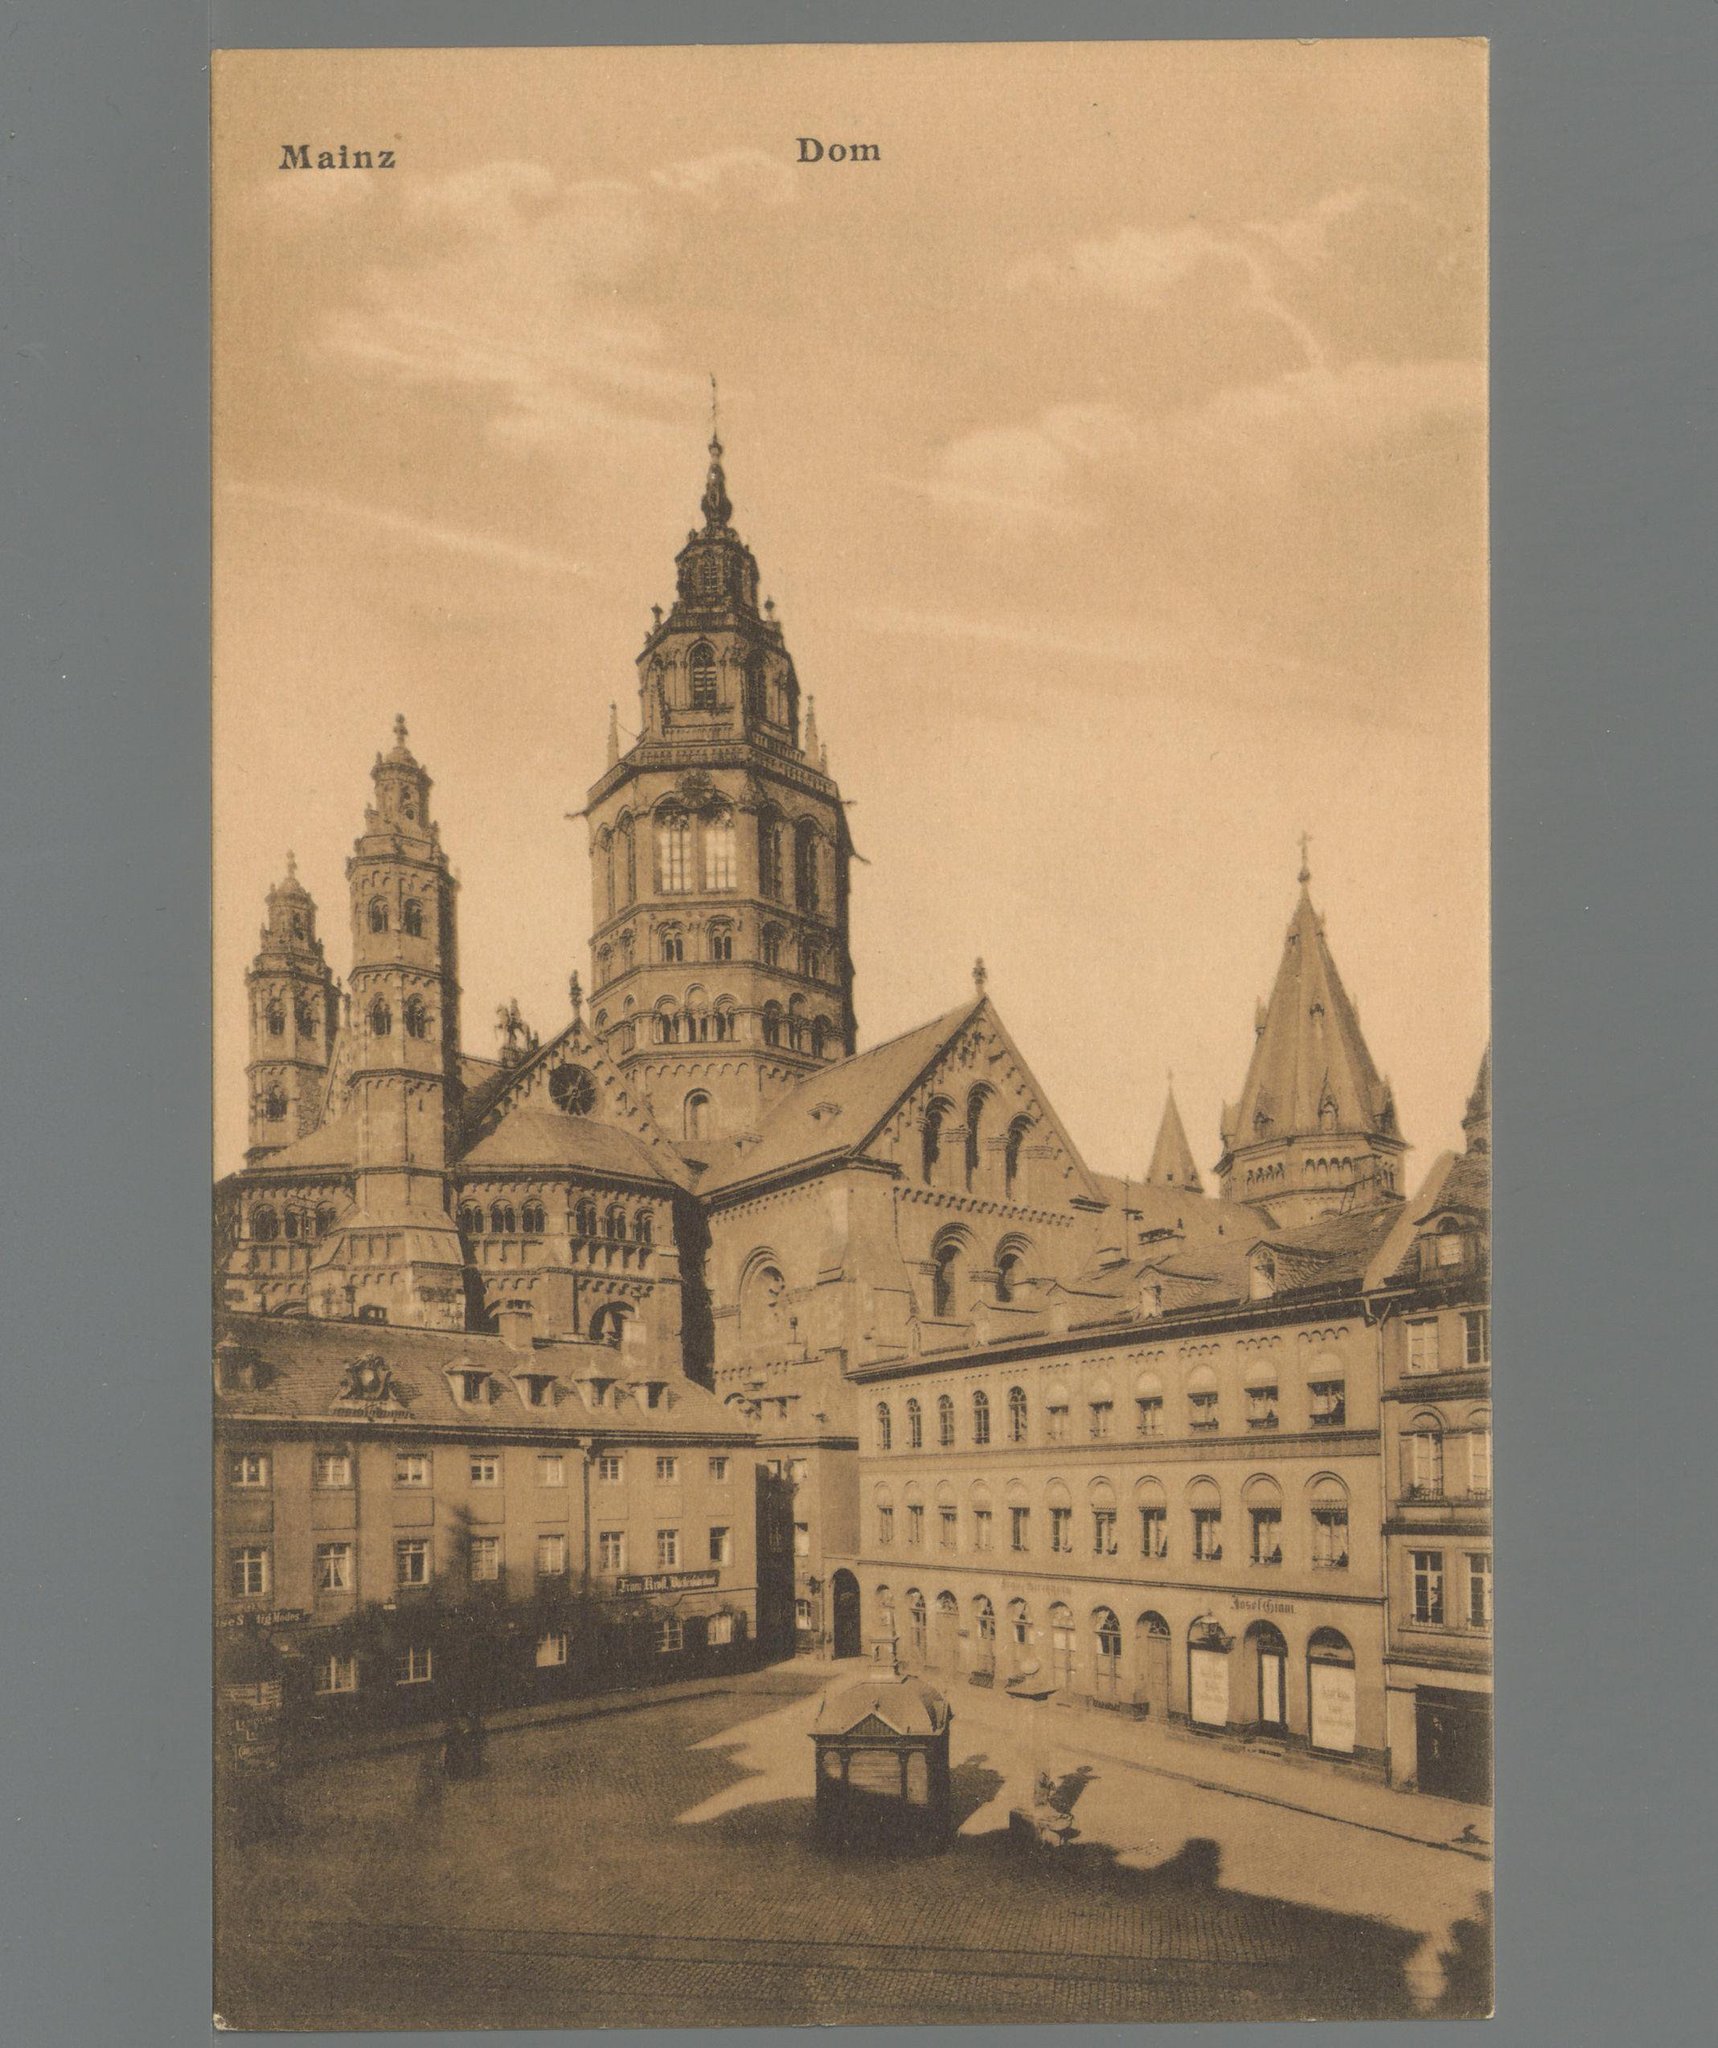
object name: photomechanical print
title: Mainz. Dom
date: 1906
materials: cardboard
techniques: photograph, writing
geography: magdeburg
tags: square, place, circus, etc., church (exterior)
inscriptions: date